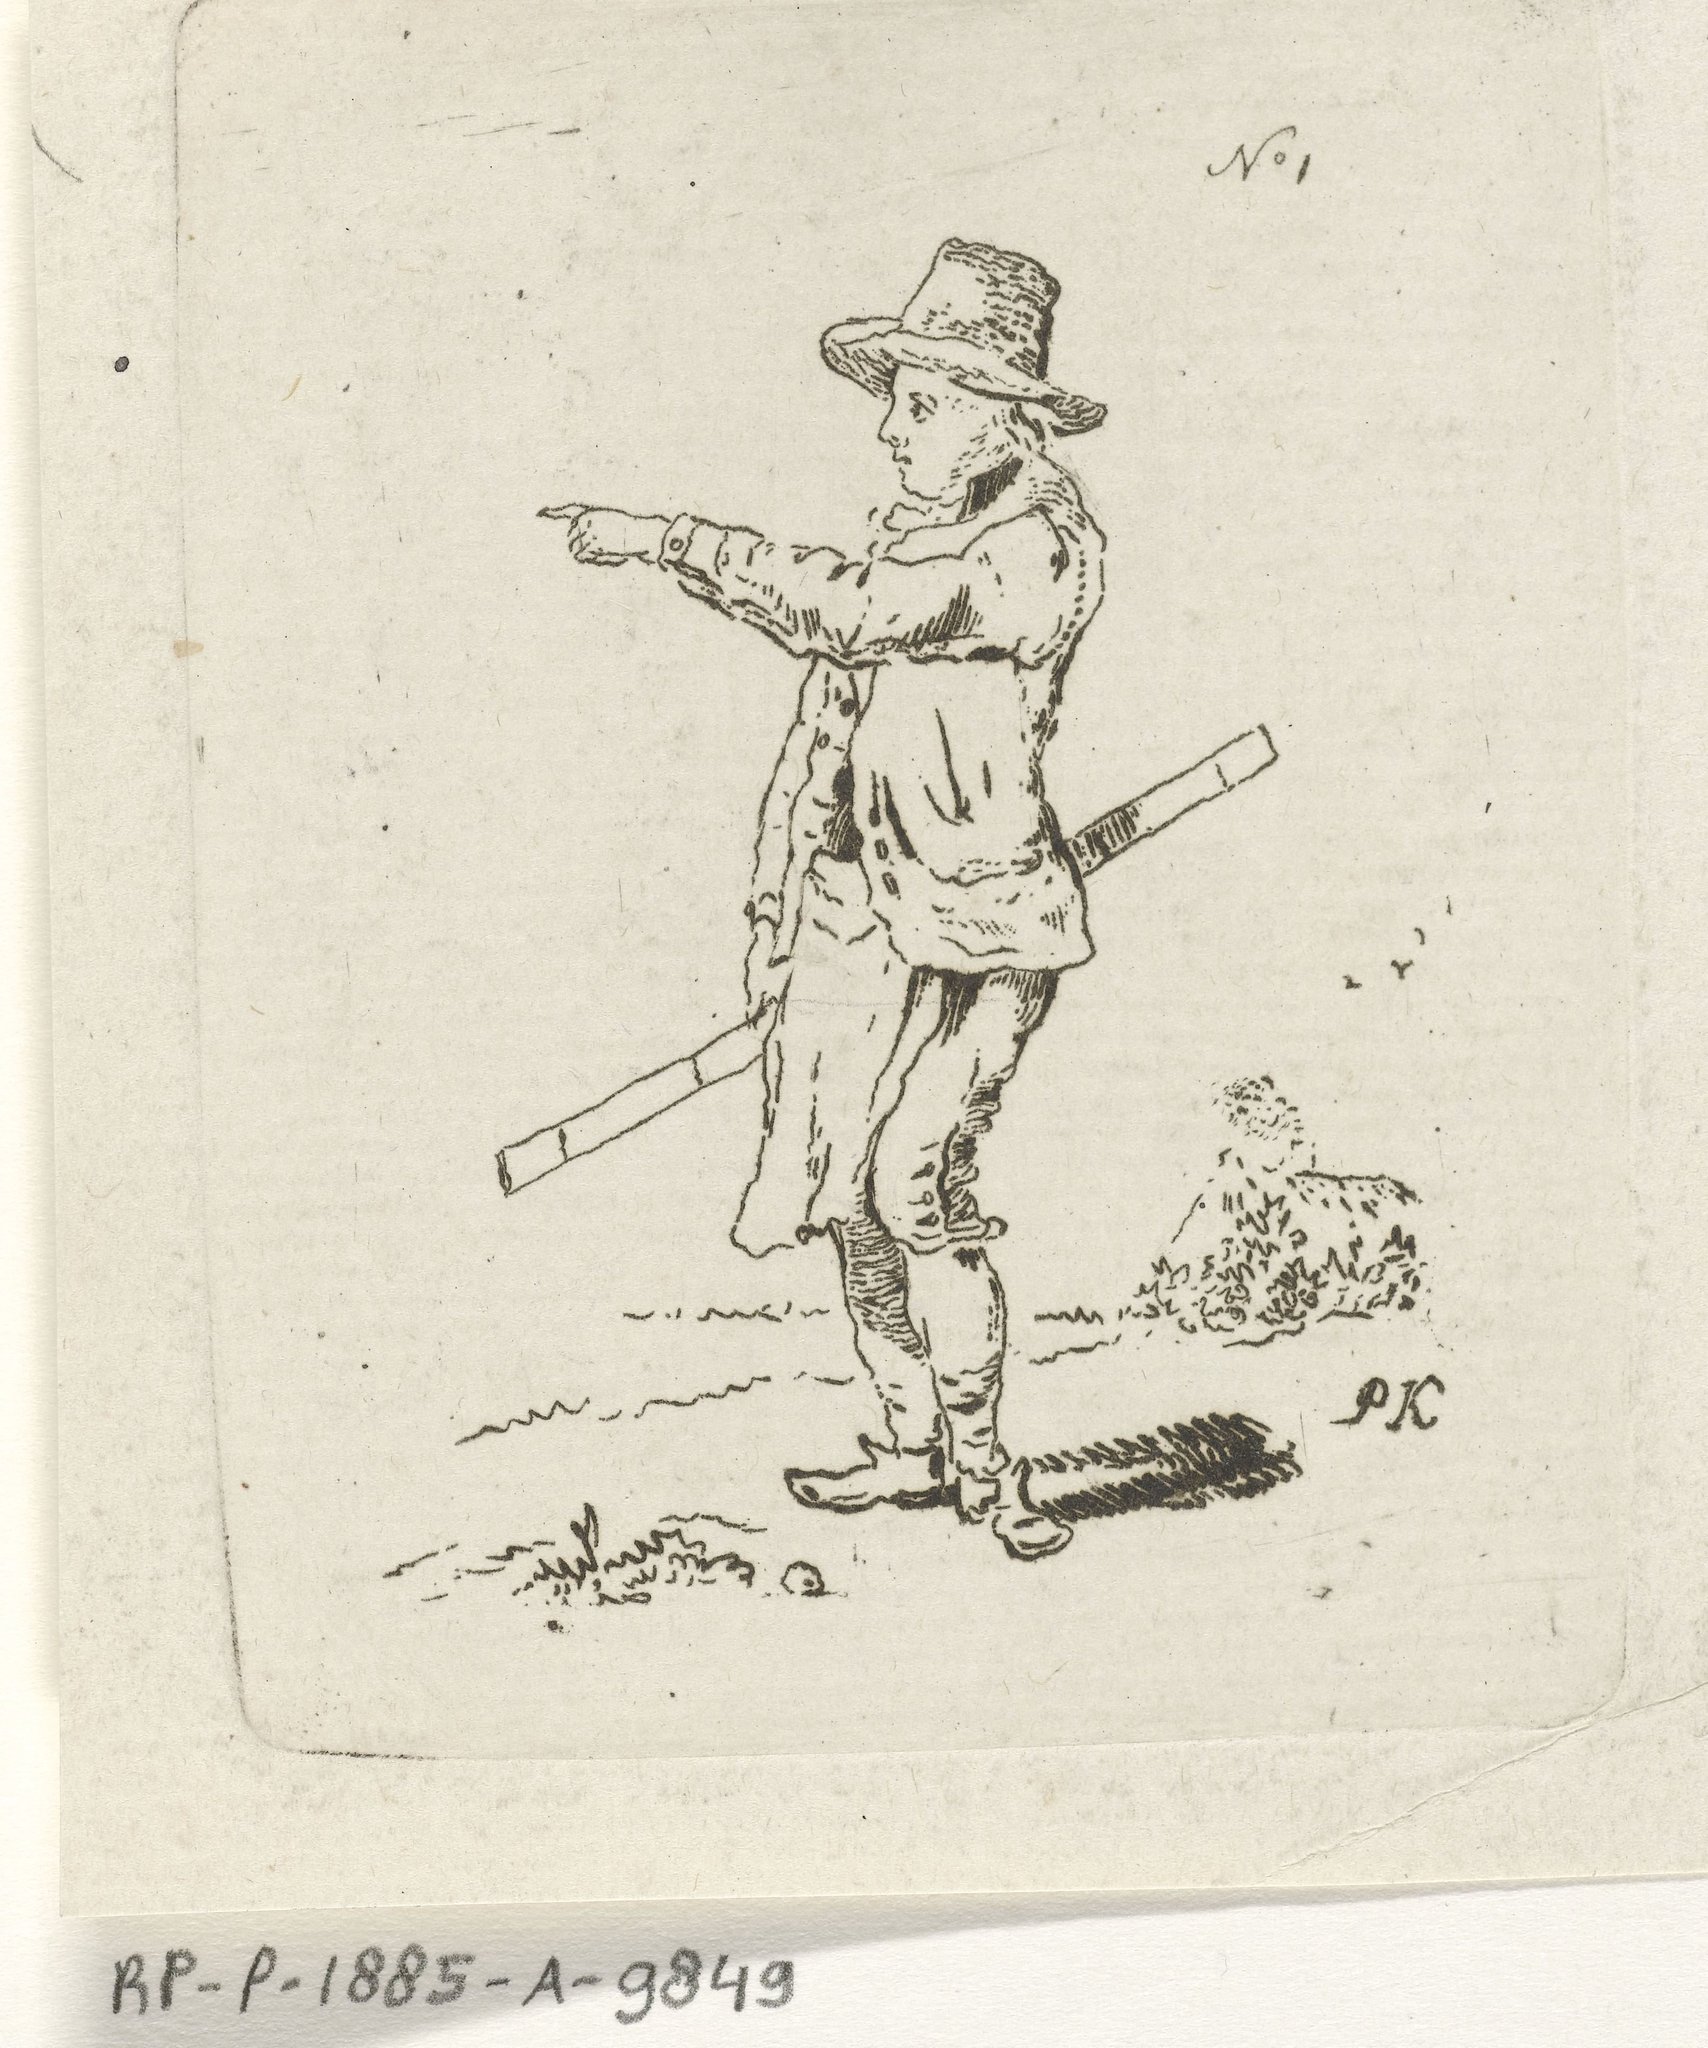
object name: print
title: Man met maatstok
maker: pieter kikkert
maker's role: print maker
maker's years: 1775-1855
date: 1785-1855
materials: paper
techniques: etching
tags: measuring-instruments, adult man (+ sideview, profile)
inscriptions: inscription: ‘Van Riemsdijk’, collector's mark: Lugt 2228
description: Een man met een schort om en een hoed op in profiel naar links, wijst met zijn linkerhand. In zijn rechterhand heeft hij een maatstok.